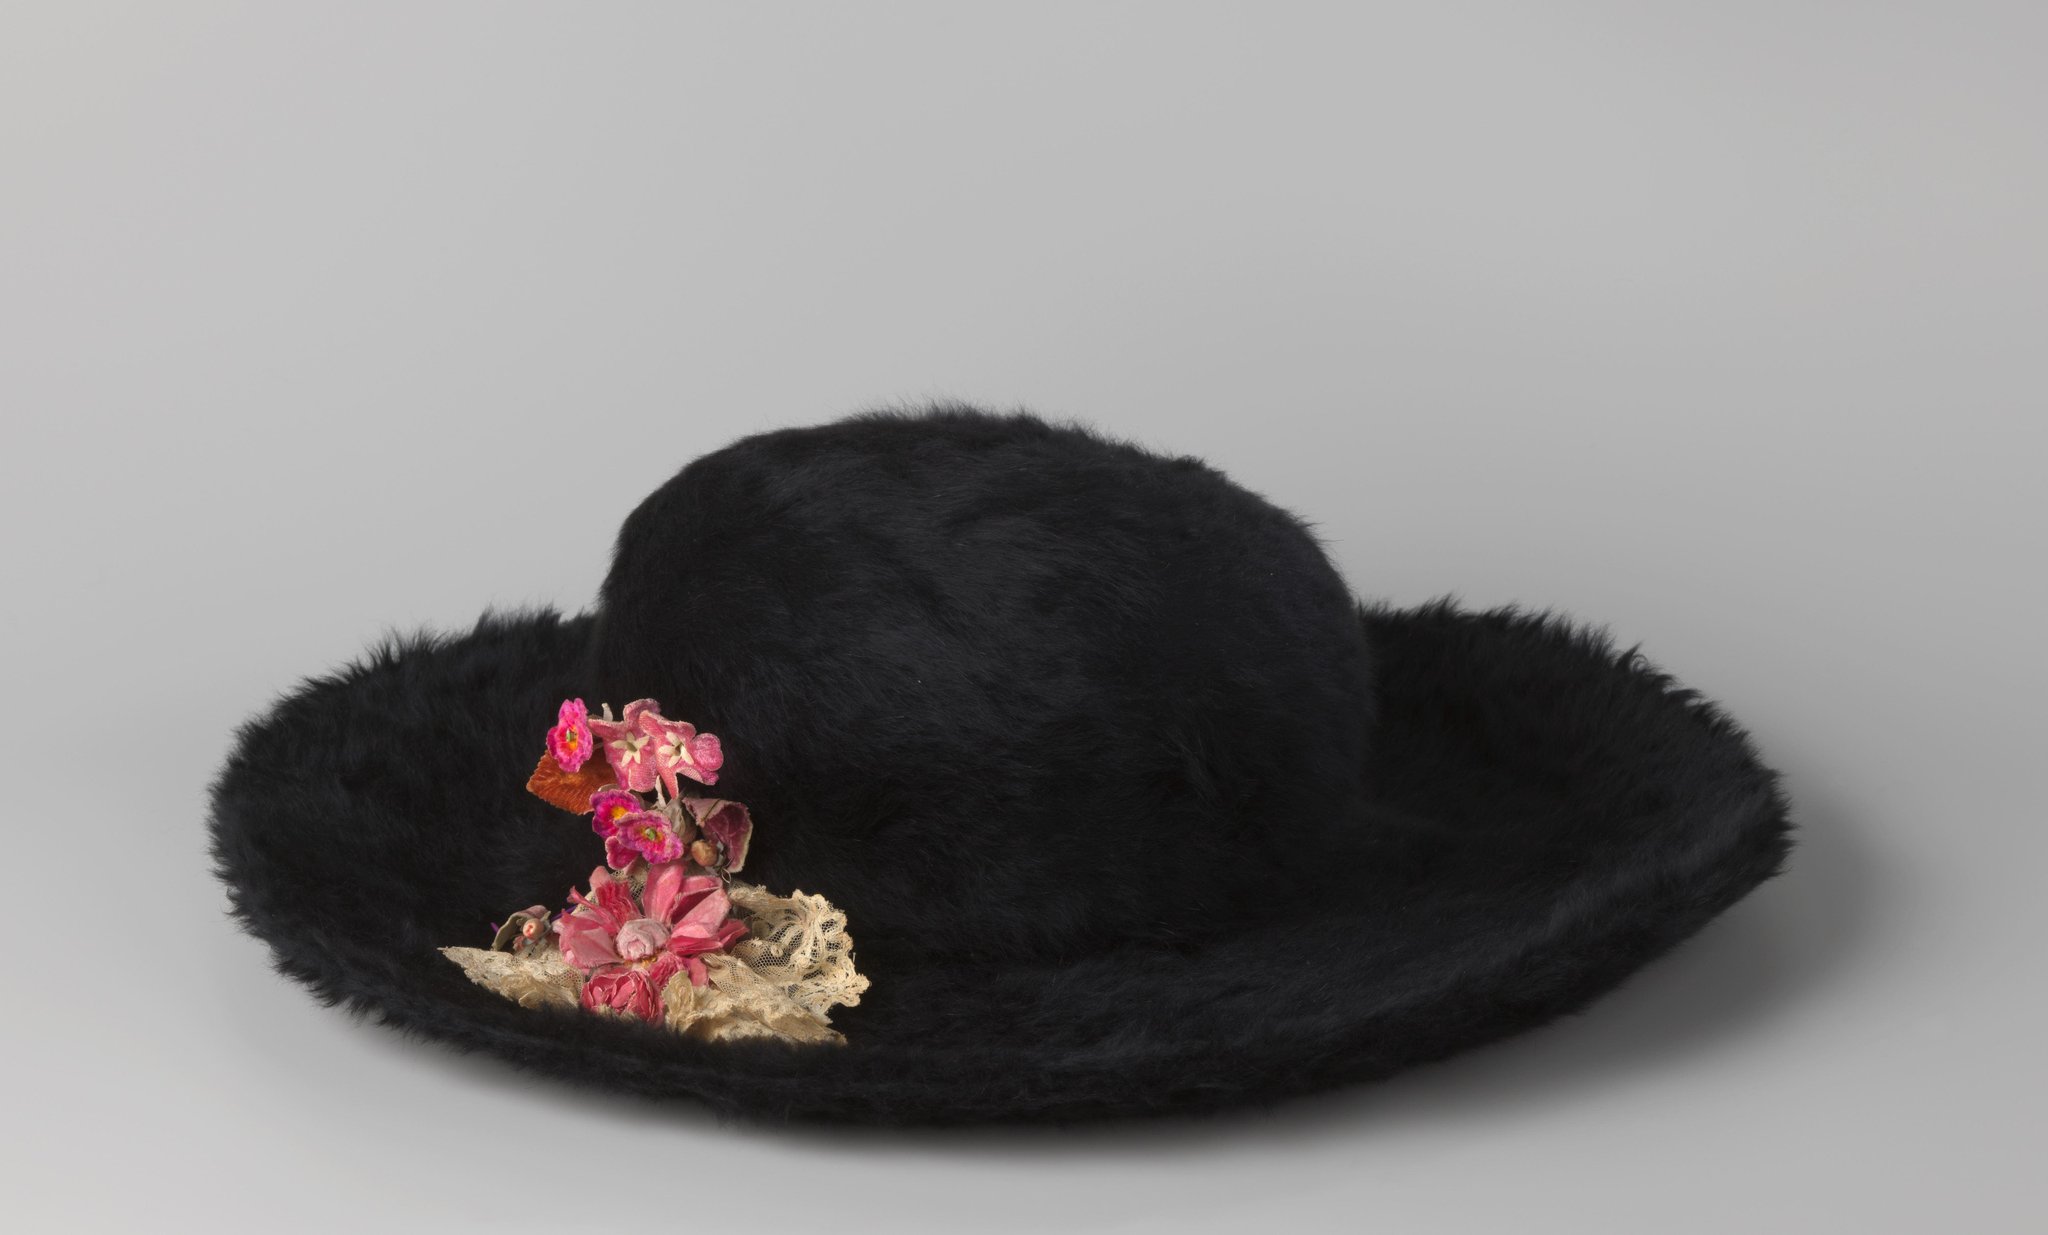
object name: womenswear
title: Hoed van zwarte castor, wagenwielmodel, voeringskap met intrekband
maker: Anonymous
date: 1910-1915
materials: felt, metal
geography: western europe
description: Hoed van zwarte castor, of langharig vilt. Model: Wagenwiel. vrij hoge ronde bol, zeer brede rand. Staande binnenwand in de bol, van dubbel laiton. Zwart voeringskap met intrekband.